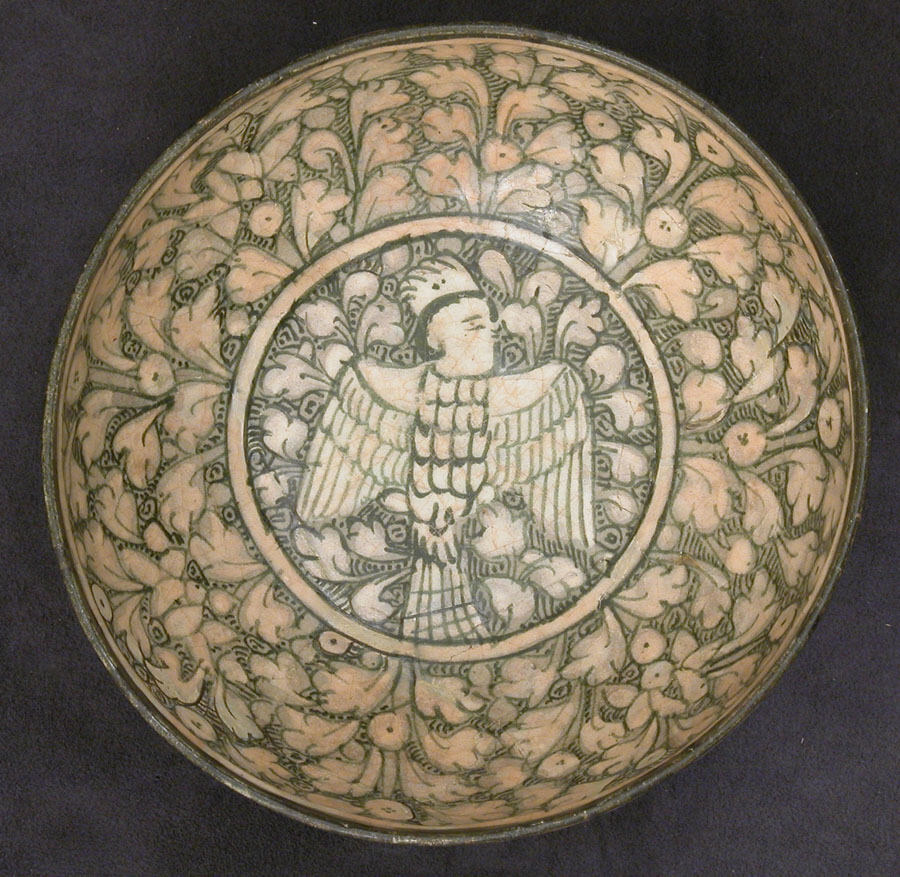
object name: bowl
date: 1301-1400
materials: earthenware, glaze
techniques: painting, underglaze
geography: iran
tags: mythical creatures,leaves